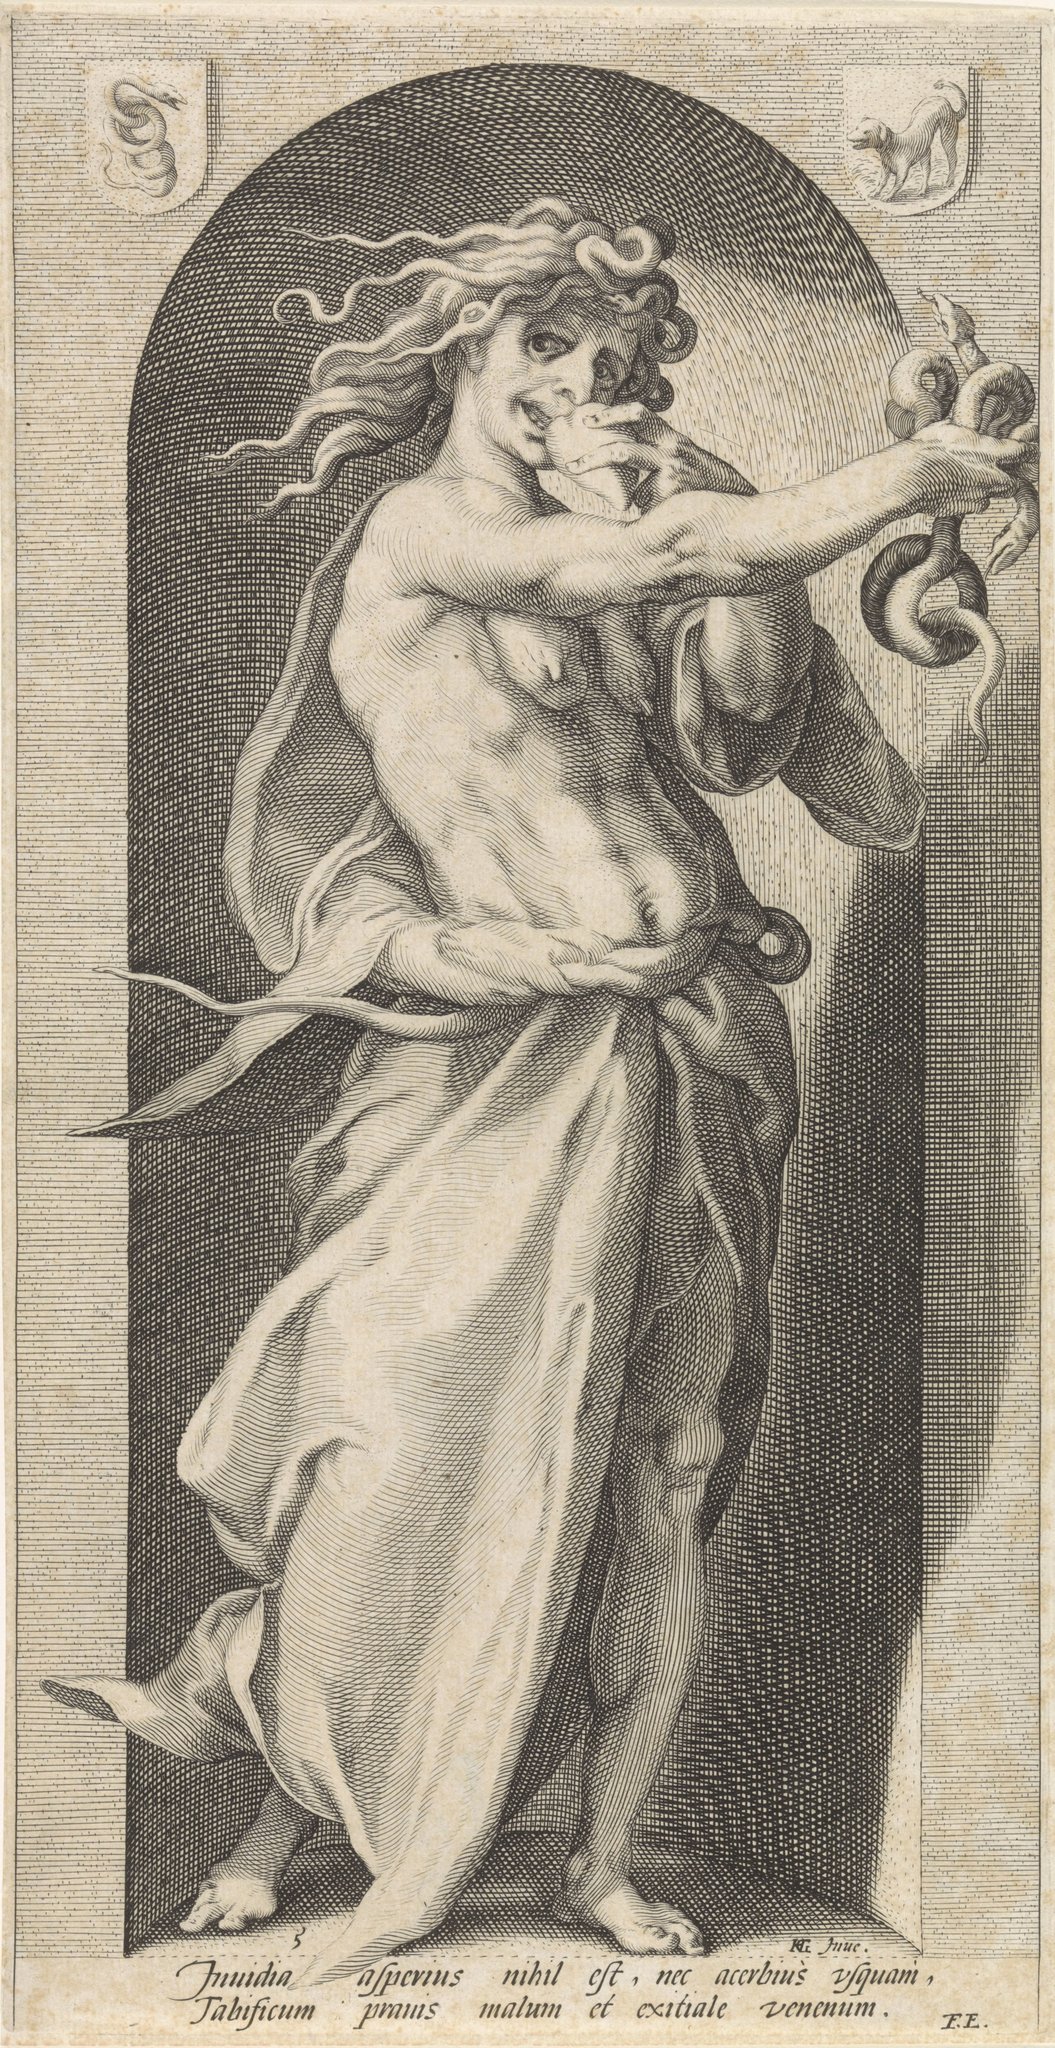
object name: print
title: Afgunst (Invidia)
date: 1593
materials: paper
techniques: engraving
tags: envy; 'invidia' (ripa) ~ personification of one of the seven deadly sins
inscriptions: collector's mark: Lugt 2228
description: Personificatie van de afgunst, verbeeld als vrouwenfiguur met slangen als haar, twee slangen in haar hand, knagend op een hart.